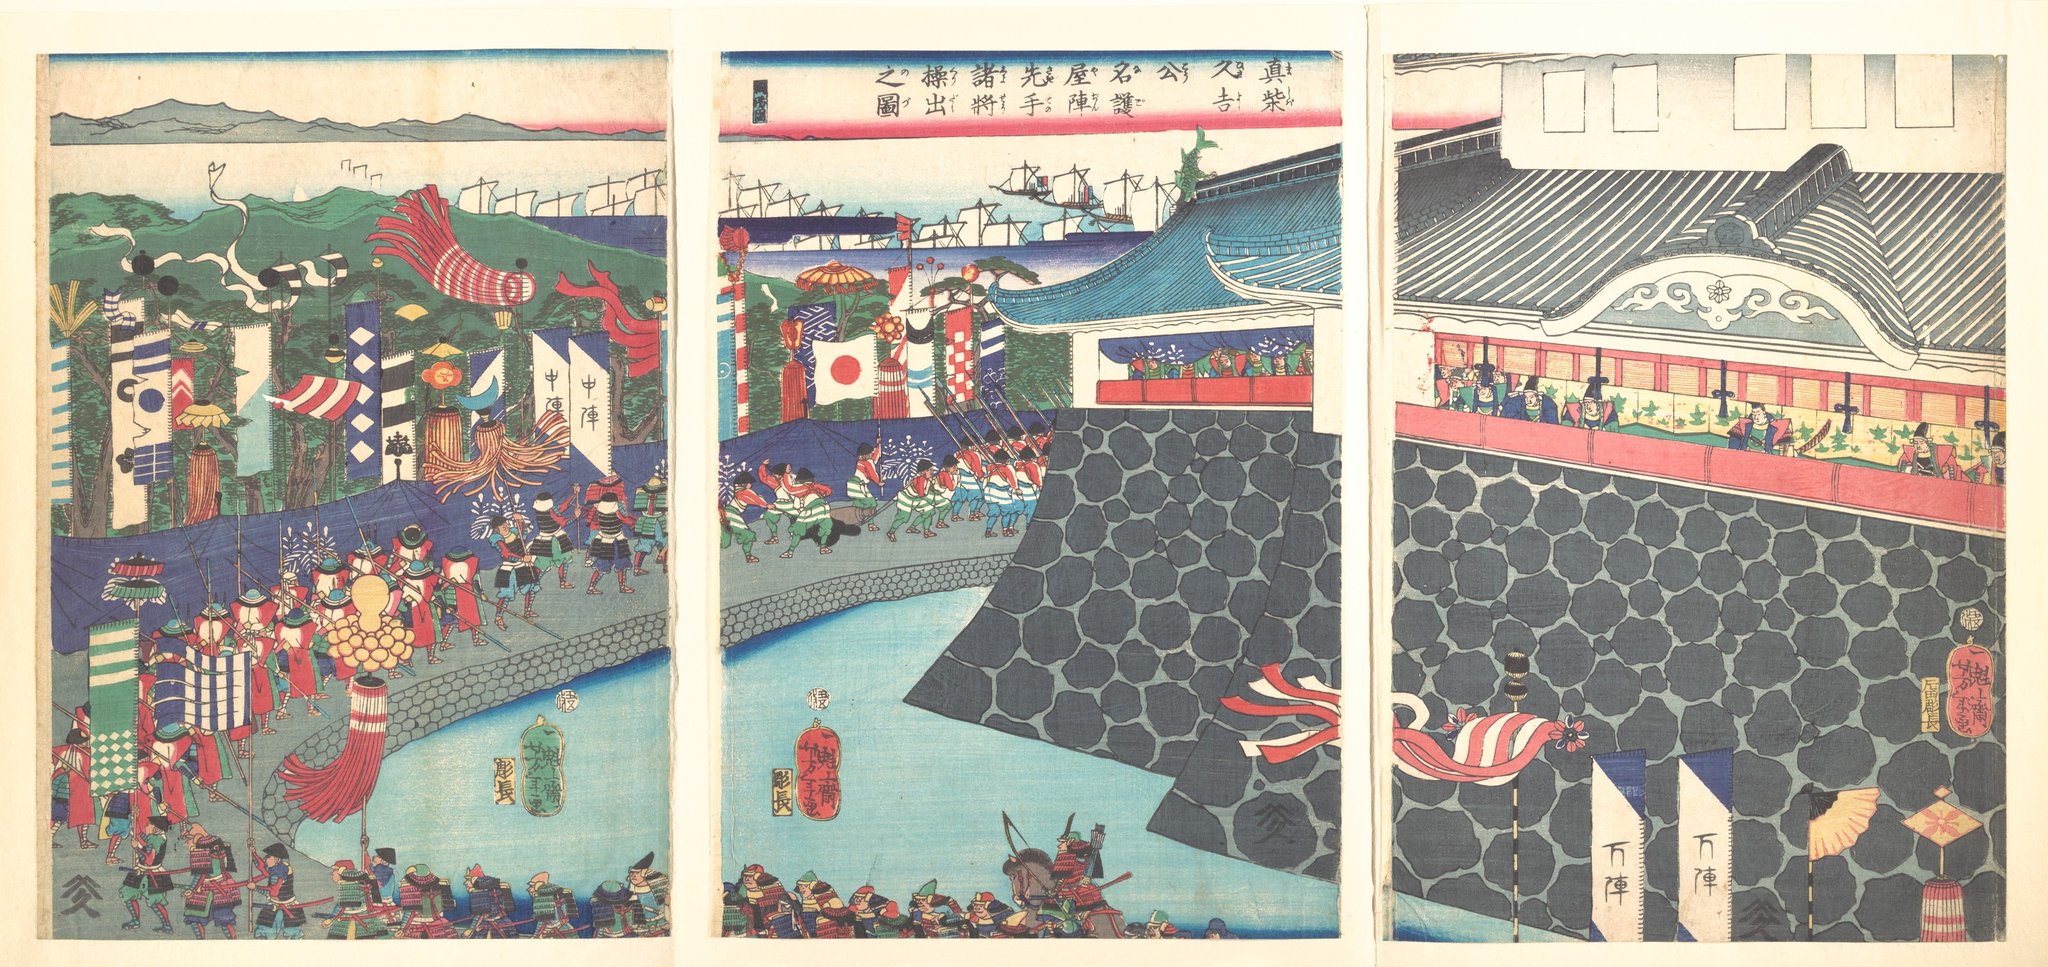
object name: print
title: Hideyoshi and His Troops Leaving Nagoya Camp (Mashiba Hideyoshi kō nagoya jin saki te no shoshō kuridashi no zu)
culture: japanese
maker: tsukioka yoshitoshi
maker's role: artist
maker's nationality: japanese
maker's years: 1839-1892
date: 1801-1900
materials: ink, paper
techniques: woodblock print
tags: soldiers,flags,processions